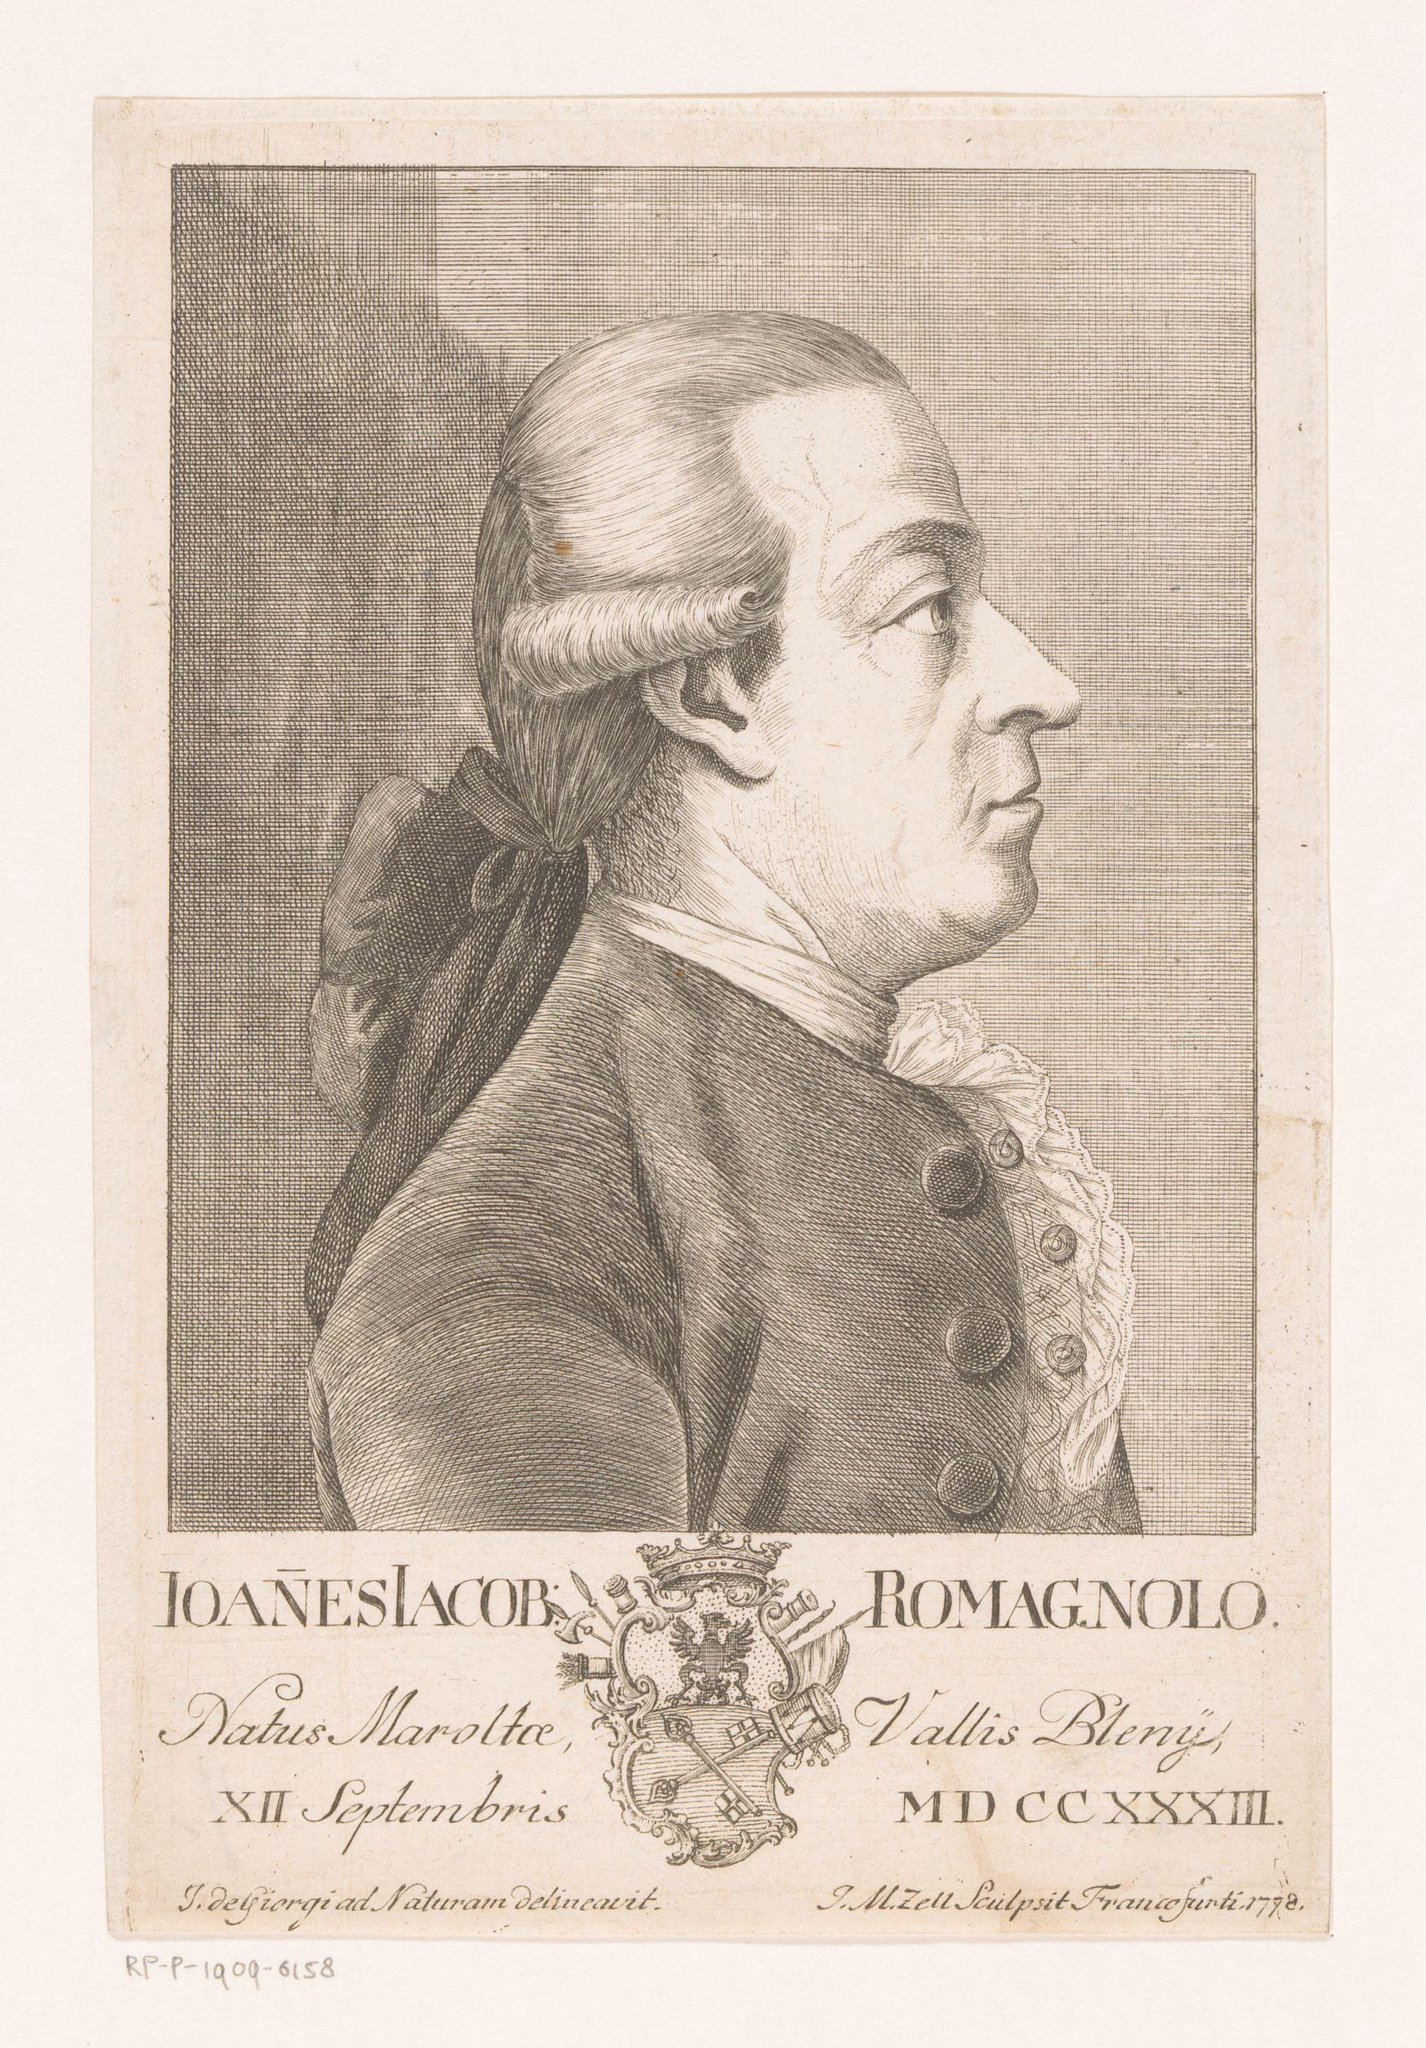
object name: print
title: Portret van Johannes Jacobus Romagnolo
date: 1778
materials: paper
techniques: etching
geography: frankfurt am main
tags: historical persons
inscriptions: collector's mark: Lugt 2228